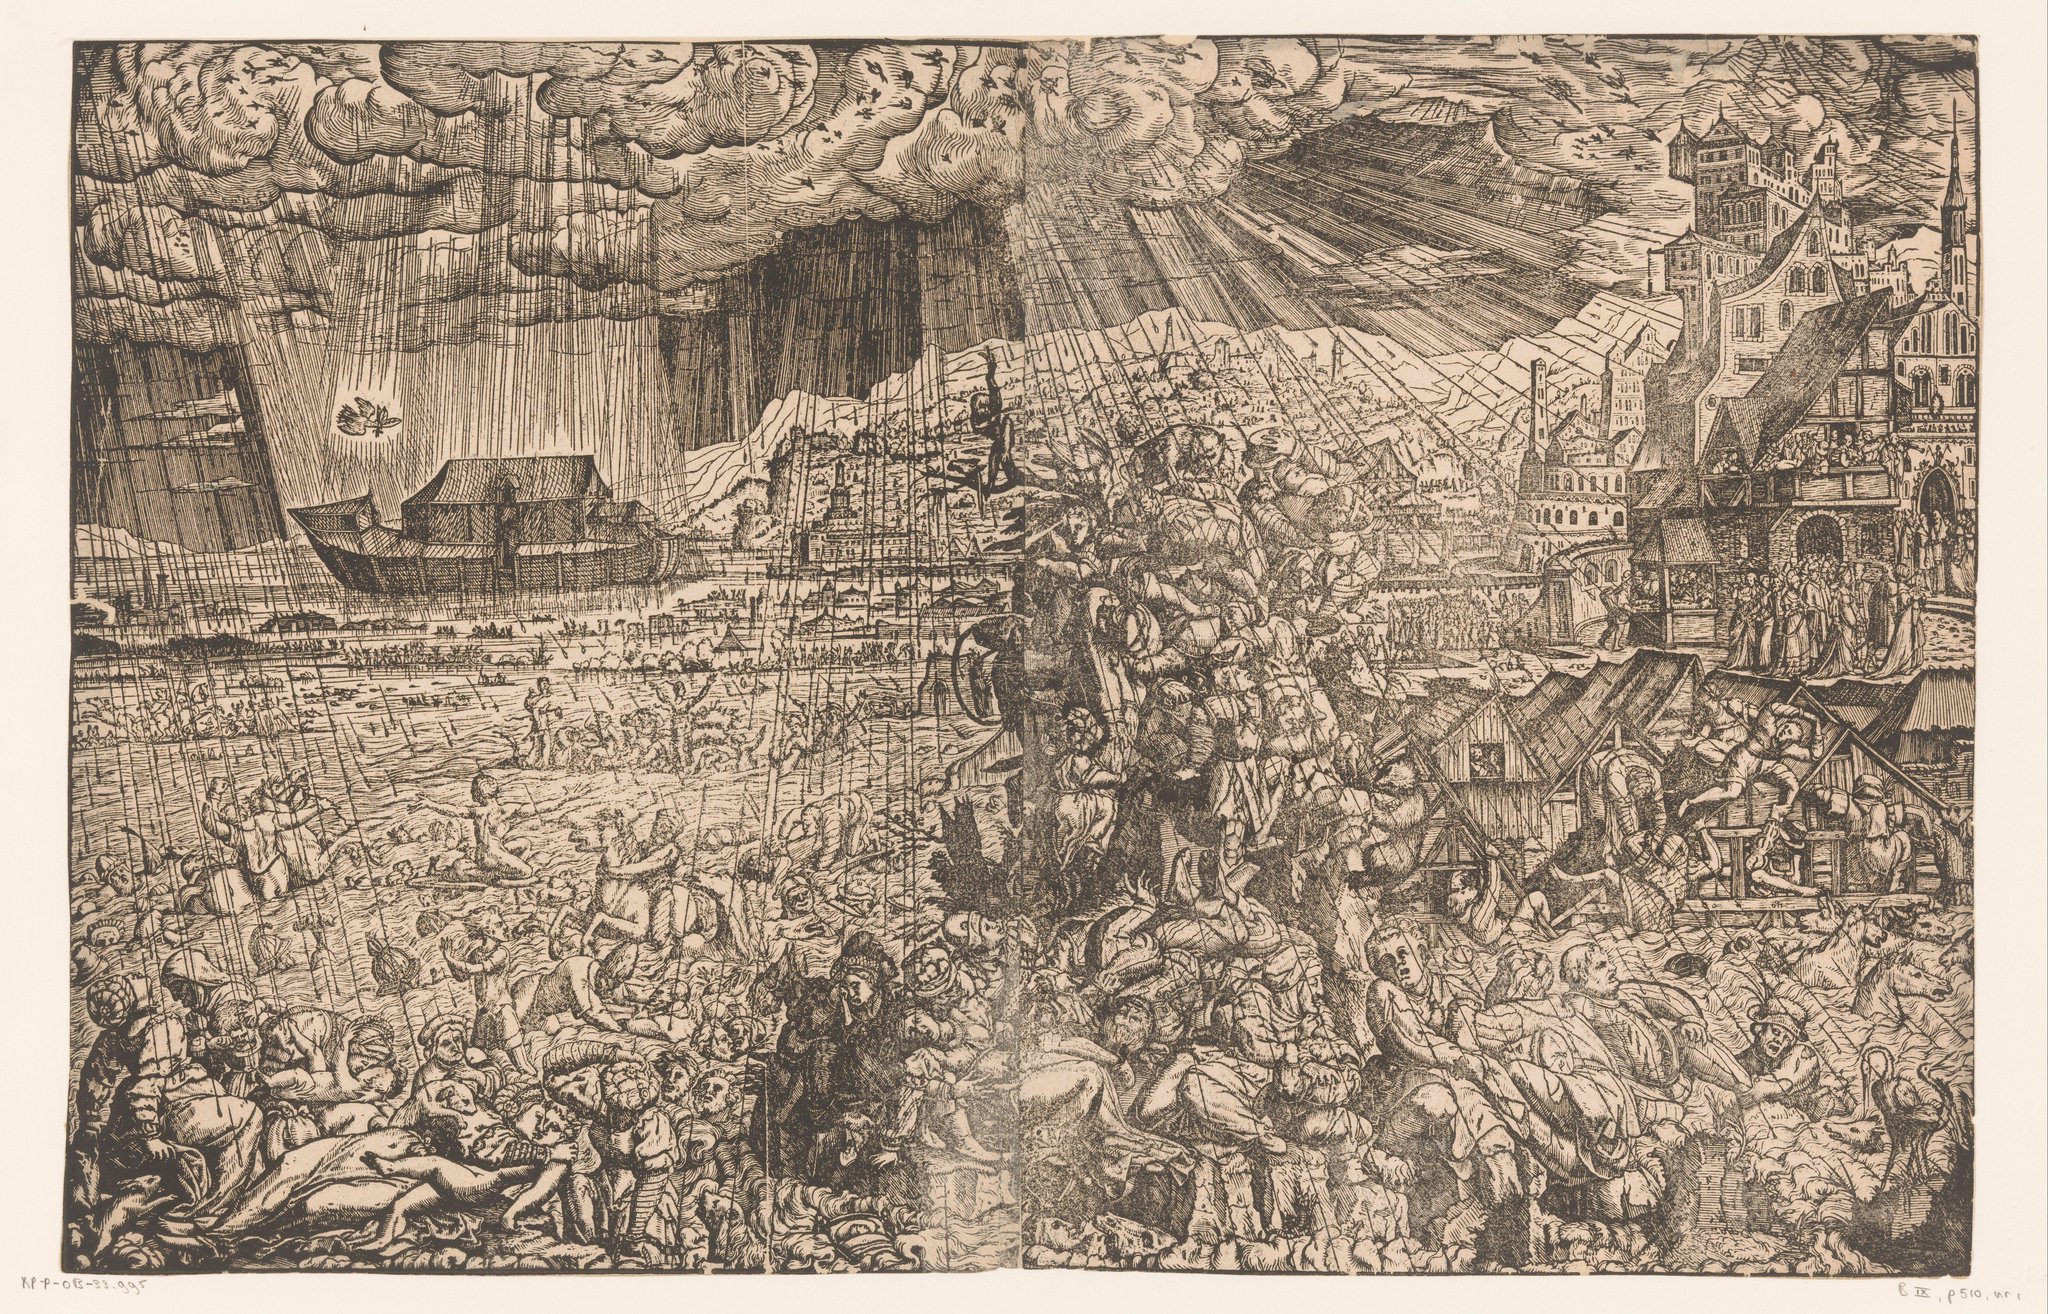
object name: print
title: De Zondvloed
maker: melchior lorck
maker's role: draughtsman, painter, print maker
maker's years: 1526-1588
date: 1551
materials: paper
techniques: woodcut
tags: the flood and destruction of mankind ~ story of noah (genesis 7:10 - 8:17)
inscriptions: collector's mark: Lugt 2228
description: De Zondvloed, met links de ark van Noach en rechts een stad met mensen in de straten. Centraal op de voorgrond klauteren mensen op een rots in een poging om aan het water te ontkomen.